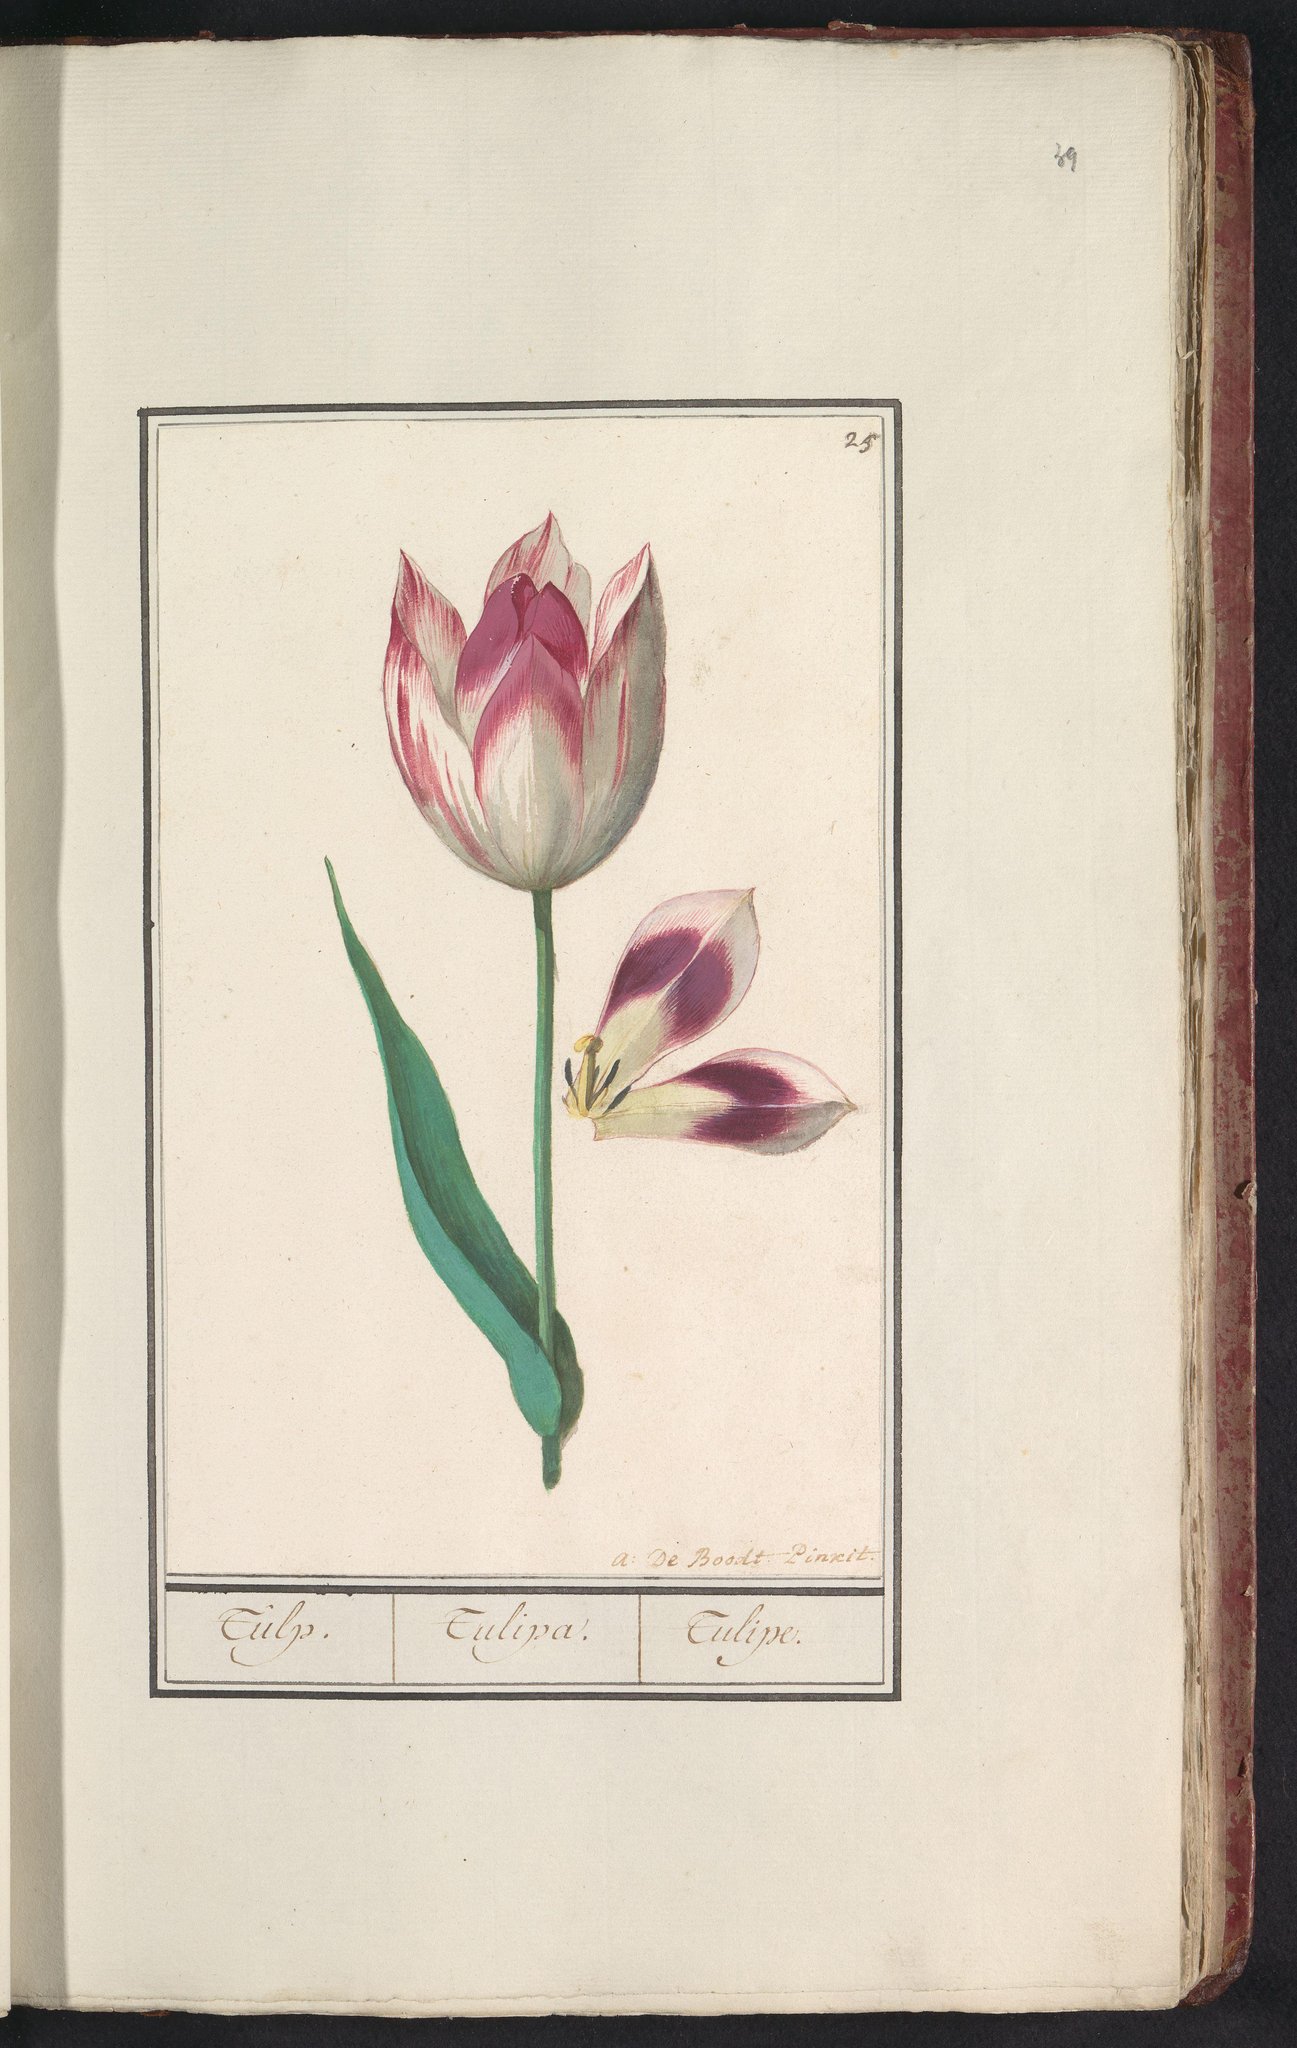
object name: drawing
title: Tulp. / Tulipa. / Tulipe.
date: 1596-1610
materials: chalk, paint, paper, watercolor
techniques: brush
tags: flowers: tulip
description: Roze-witte tulp, met twee bloemblaadjes in detail. Genummerd rechtsboven: 25. Onderdeel van het eerste album met tekeningen van bloemen en planten. Achtste van twaalf albums met tekeningen van dieren, vogels en planten bekend rond 1600, gemaakt in opdracht van keizer Rudolf II. Met toelichting in Nederlands, Latijn en Frans.